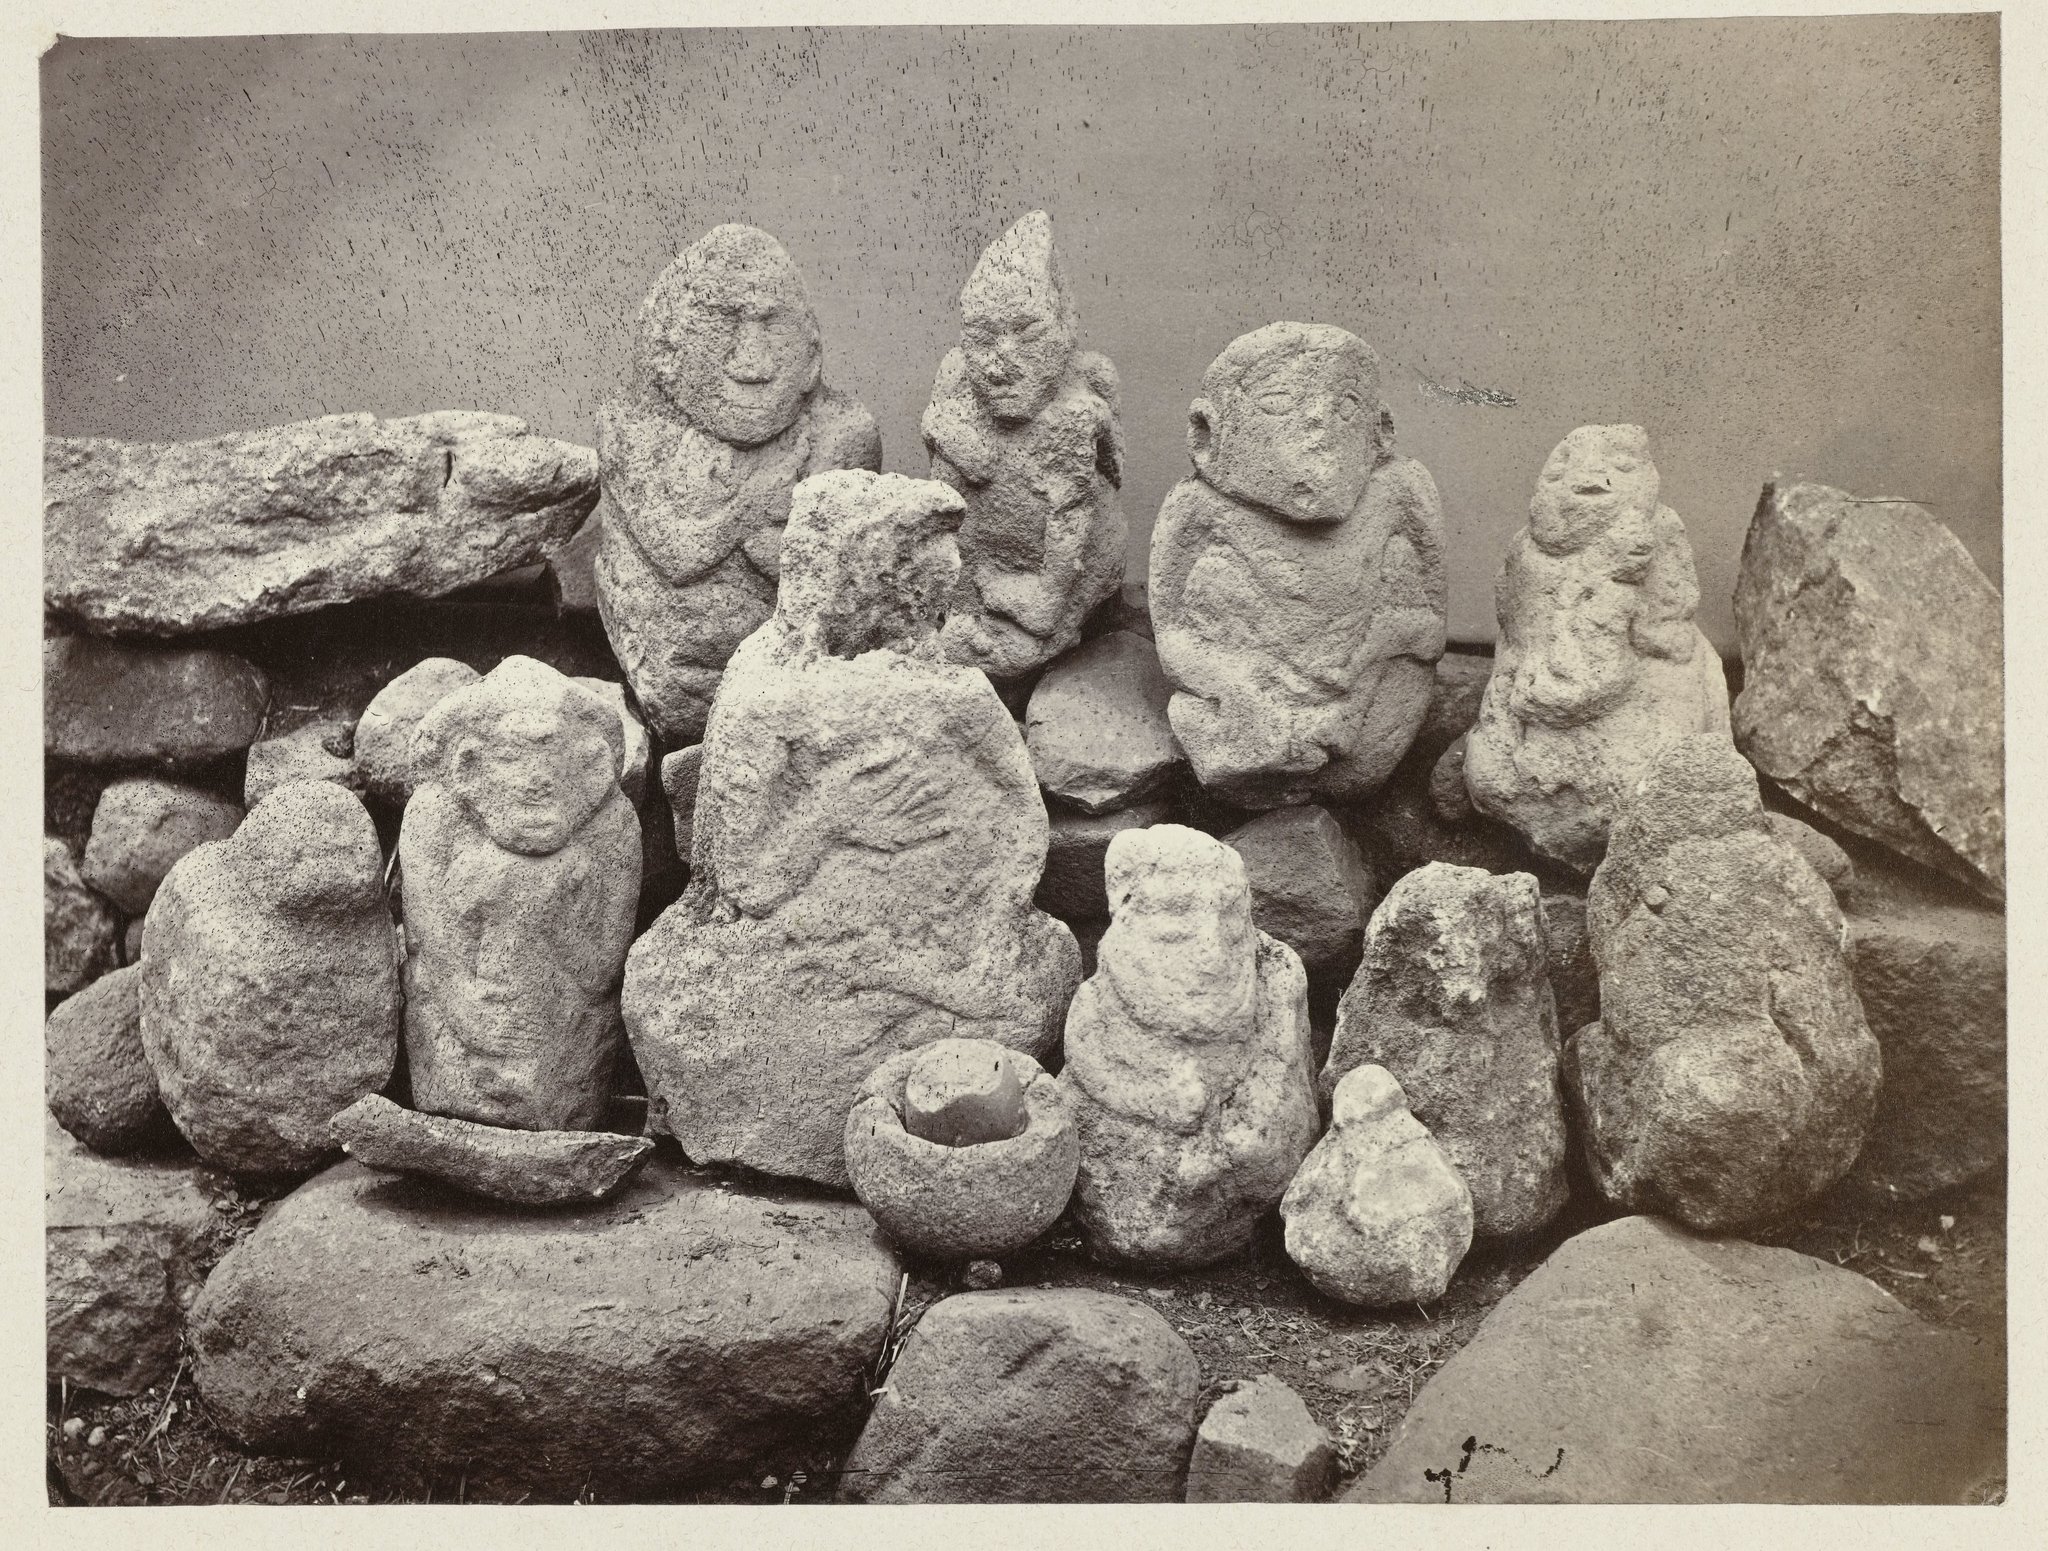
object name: photograph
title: Sacrifical place with eight ancestor sculptures, some holding a child. Mount Aki0aki, Kuningan district, West Java province, 14th-16th century.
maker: isidore kinsbergen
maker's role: fotograaf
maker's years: 1821-1905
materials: cardboard, paper, photographic support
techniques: albumen print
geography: java